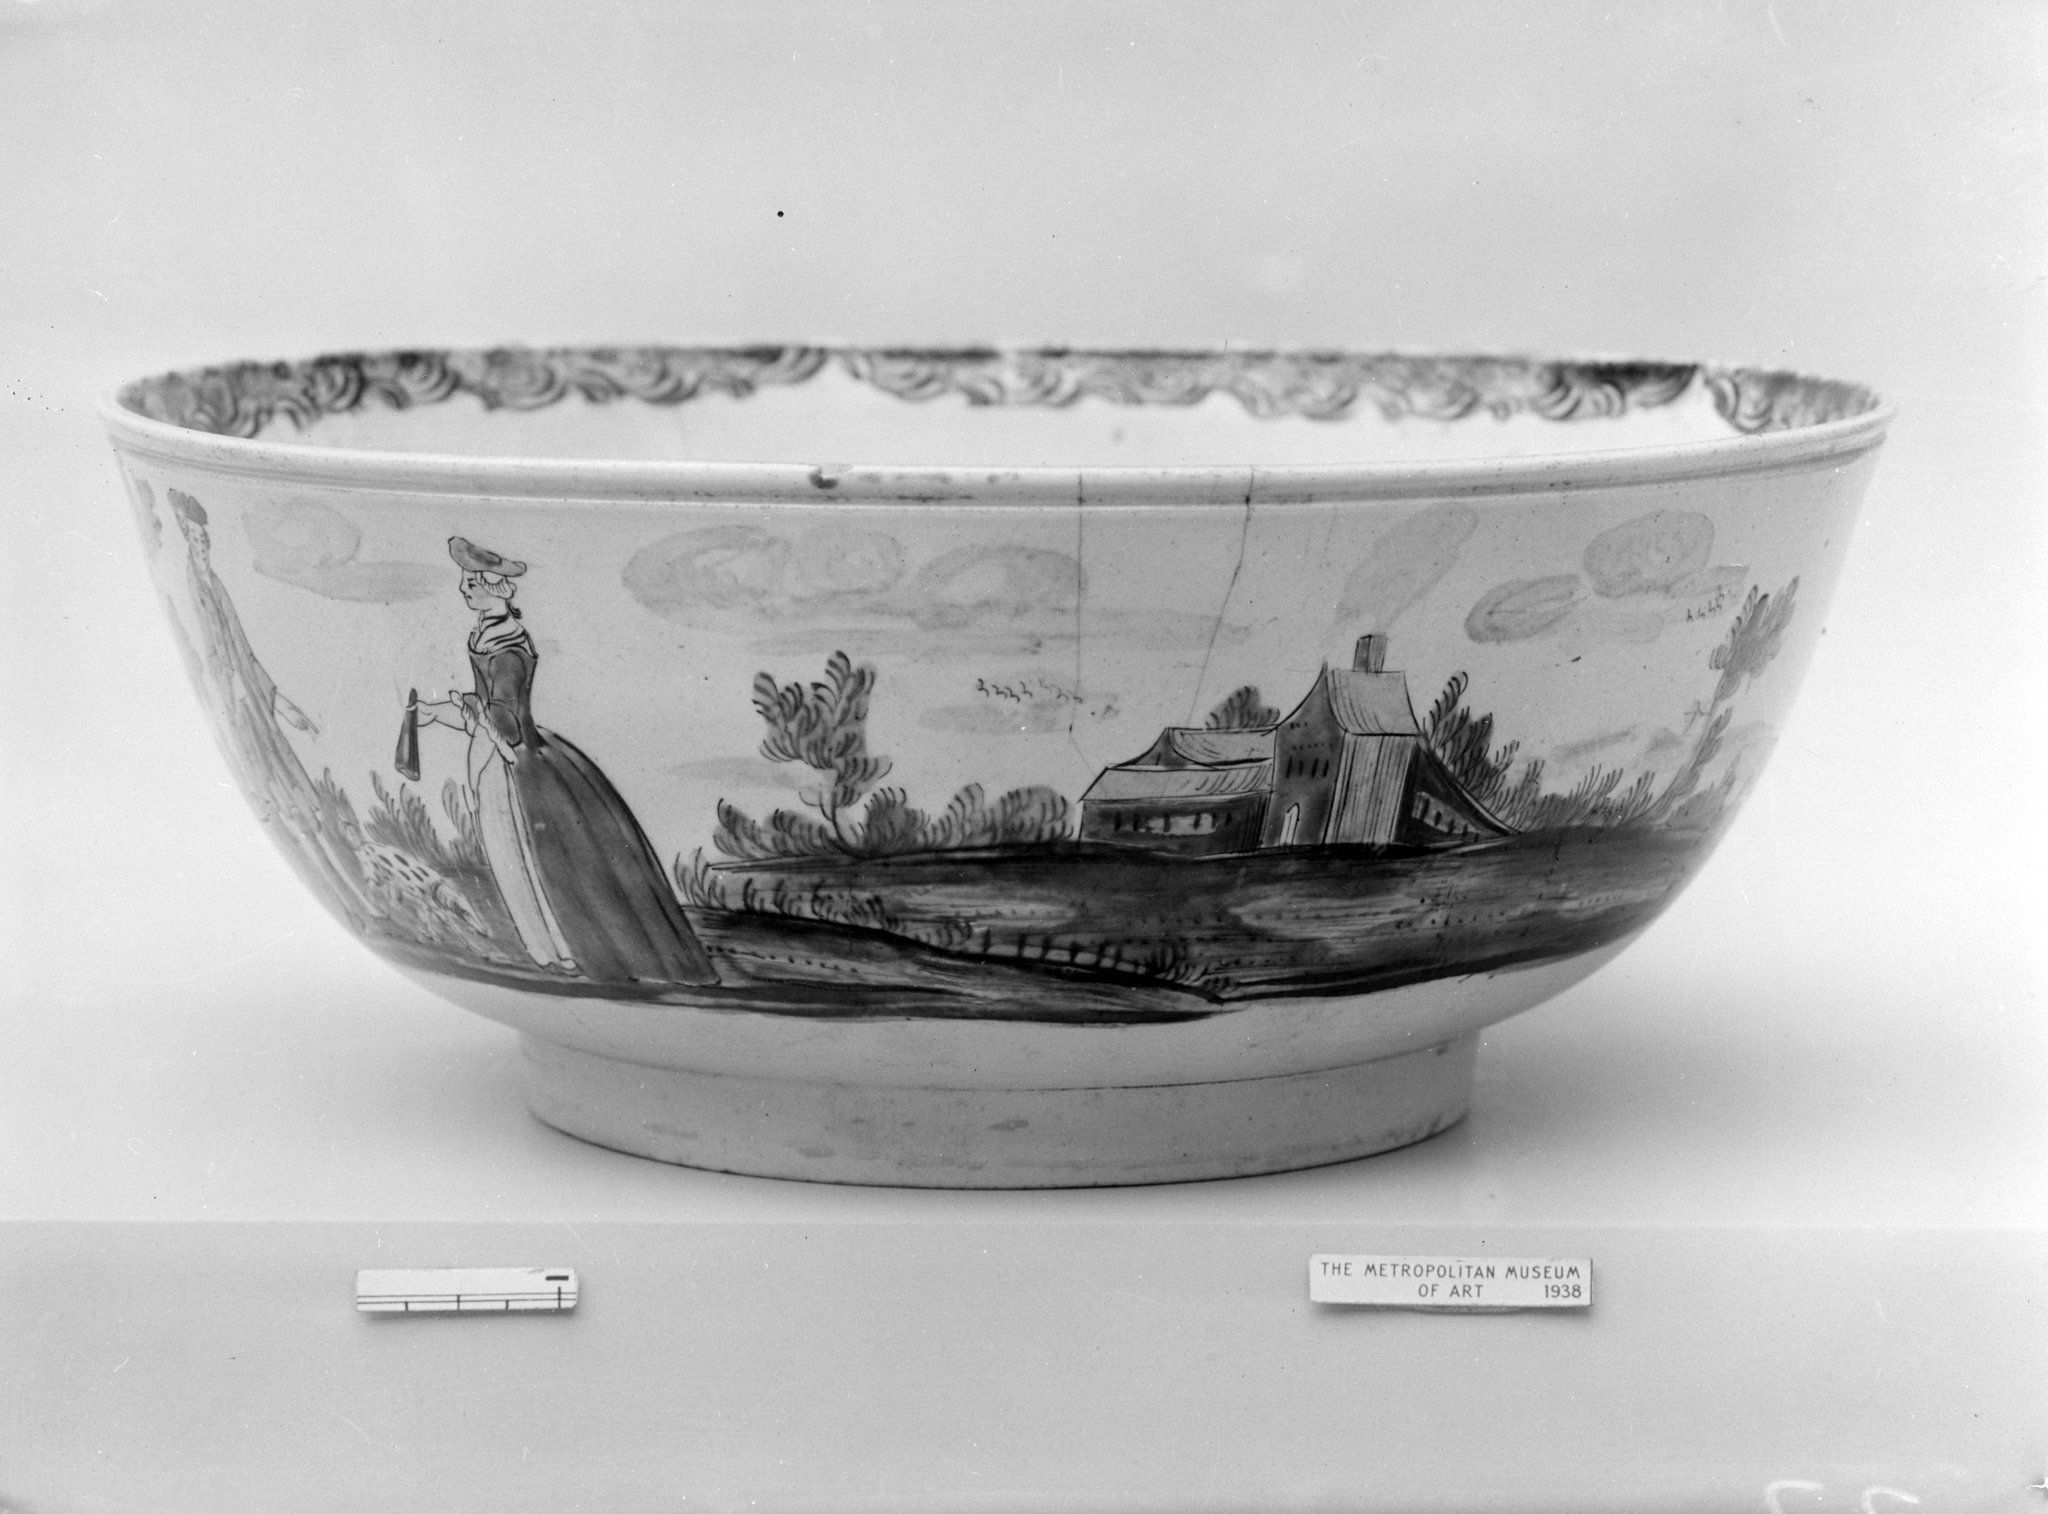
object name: bowl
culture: british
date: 1765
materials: stoneware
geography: england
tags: houses,men,women